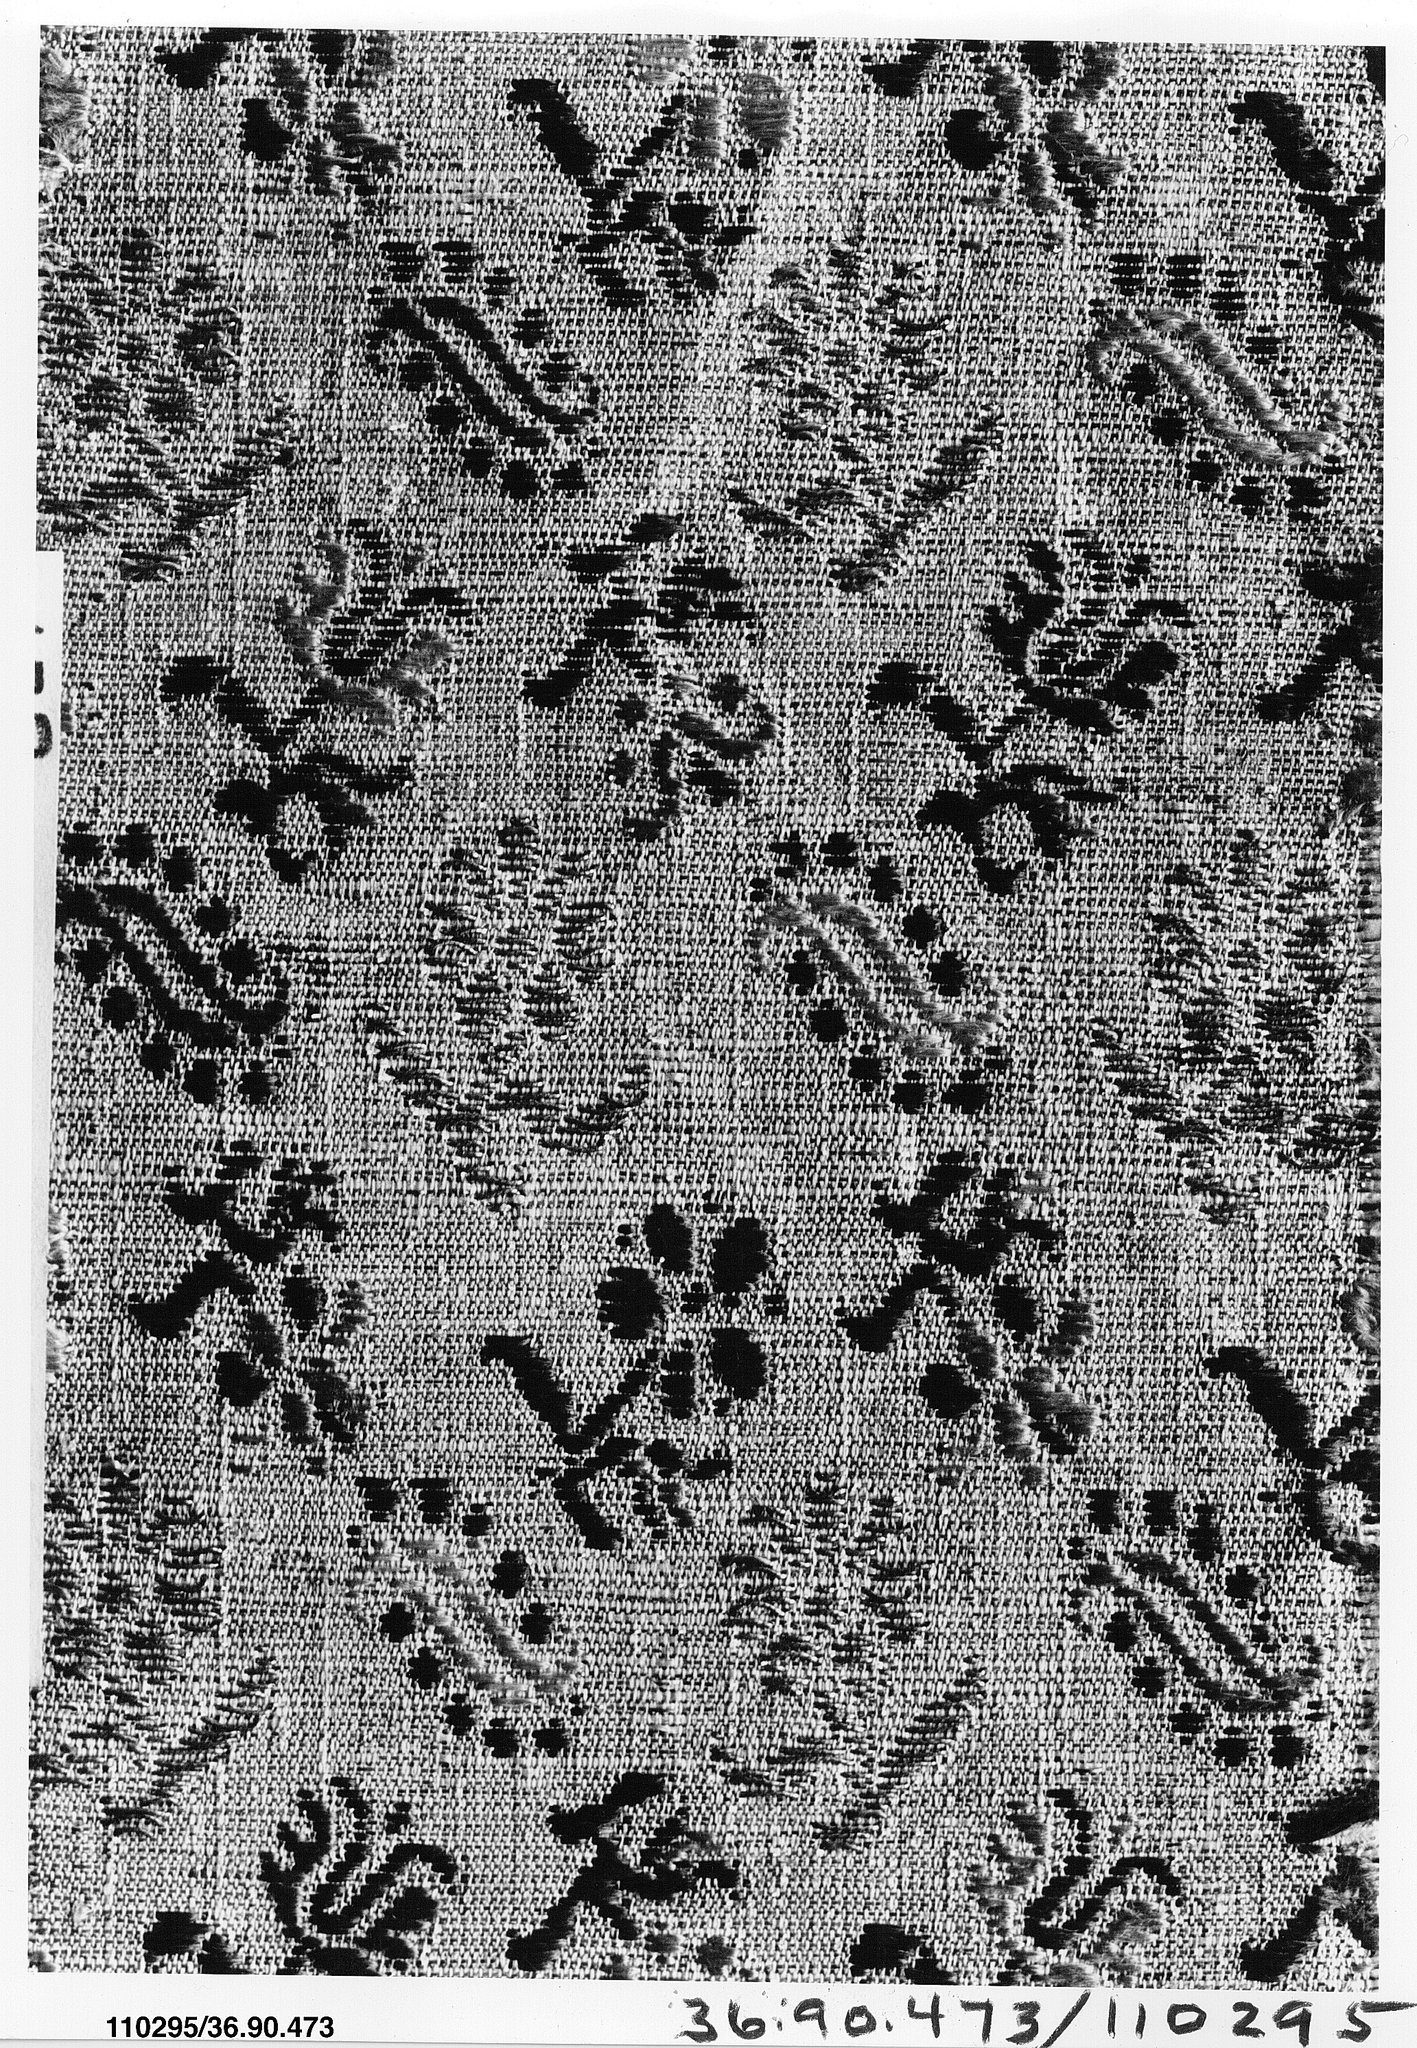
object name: piece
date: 1501-1700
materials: metal thread, silk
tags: flowers